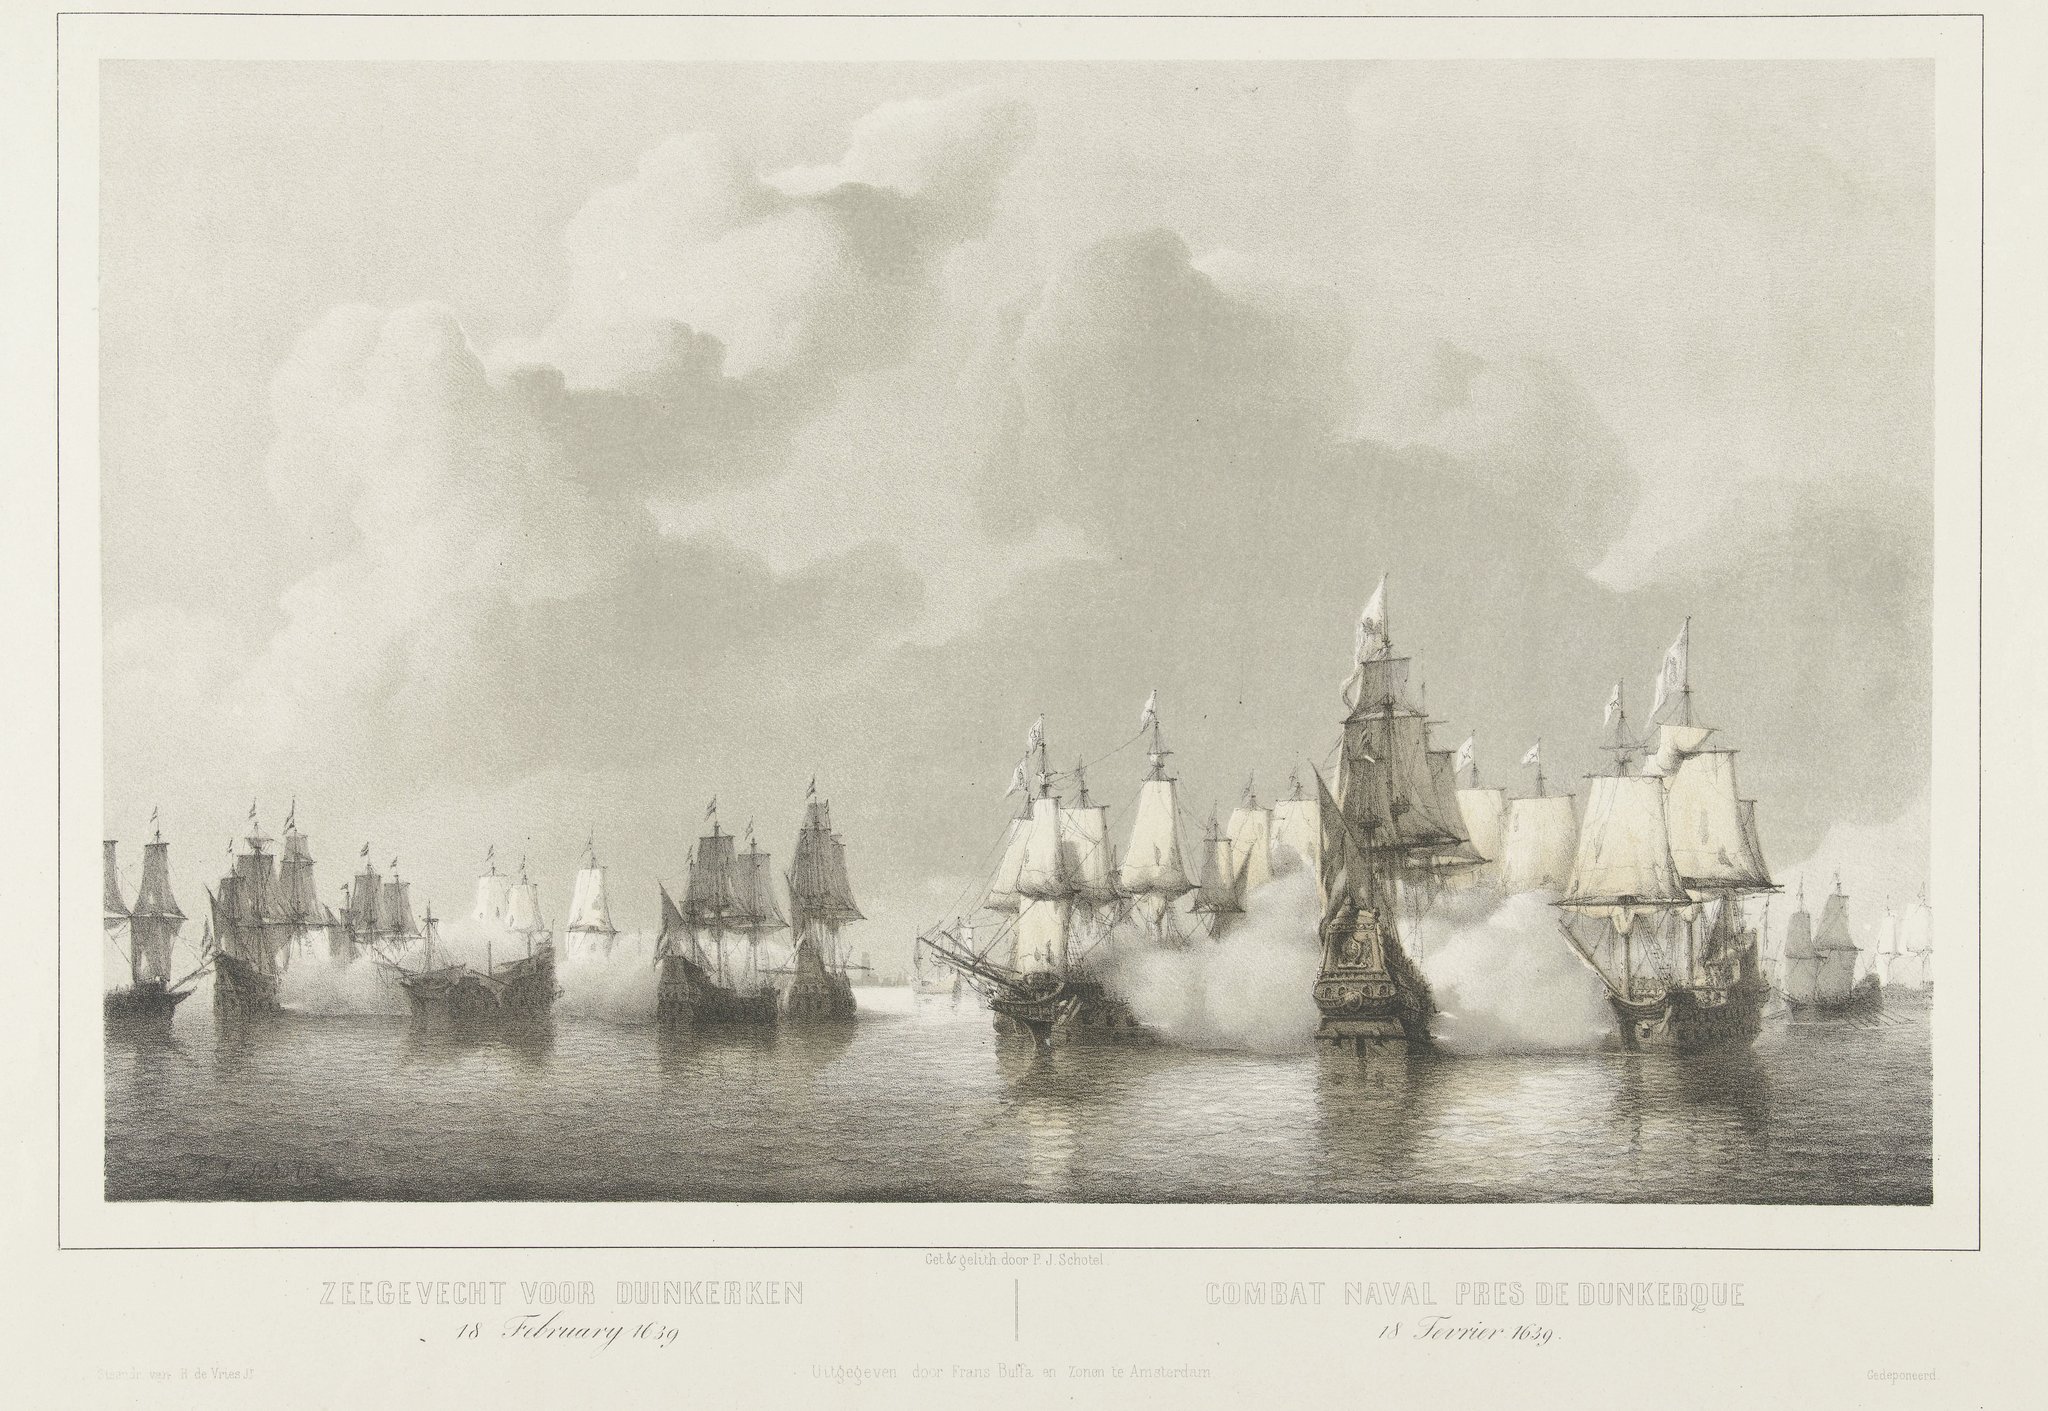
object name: print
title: Zeegevecht voor Duinkerken 18 February 1639 / Combat naval pres Dunkerque 18 Fevrier 1639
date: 1848-1855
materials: paper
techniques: lithograph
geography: netherlands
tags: brielle, maarten harpertszoon tromp, battle (+ naval force)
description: Uitgegeven in: P.J. Schotel, Heldendaden der Nederlanders ter zee, van de vroegste tijden tot op heden, naar aanleiding van de: Geschiedenis van het Nederlandsche zeewezen, Frans Buffa en Zonen, Amsterdam 1850-1855, pl. 12. Zonder de uitvoerige beschrijving vermeld bij Muller.